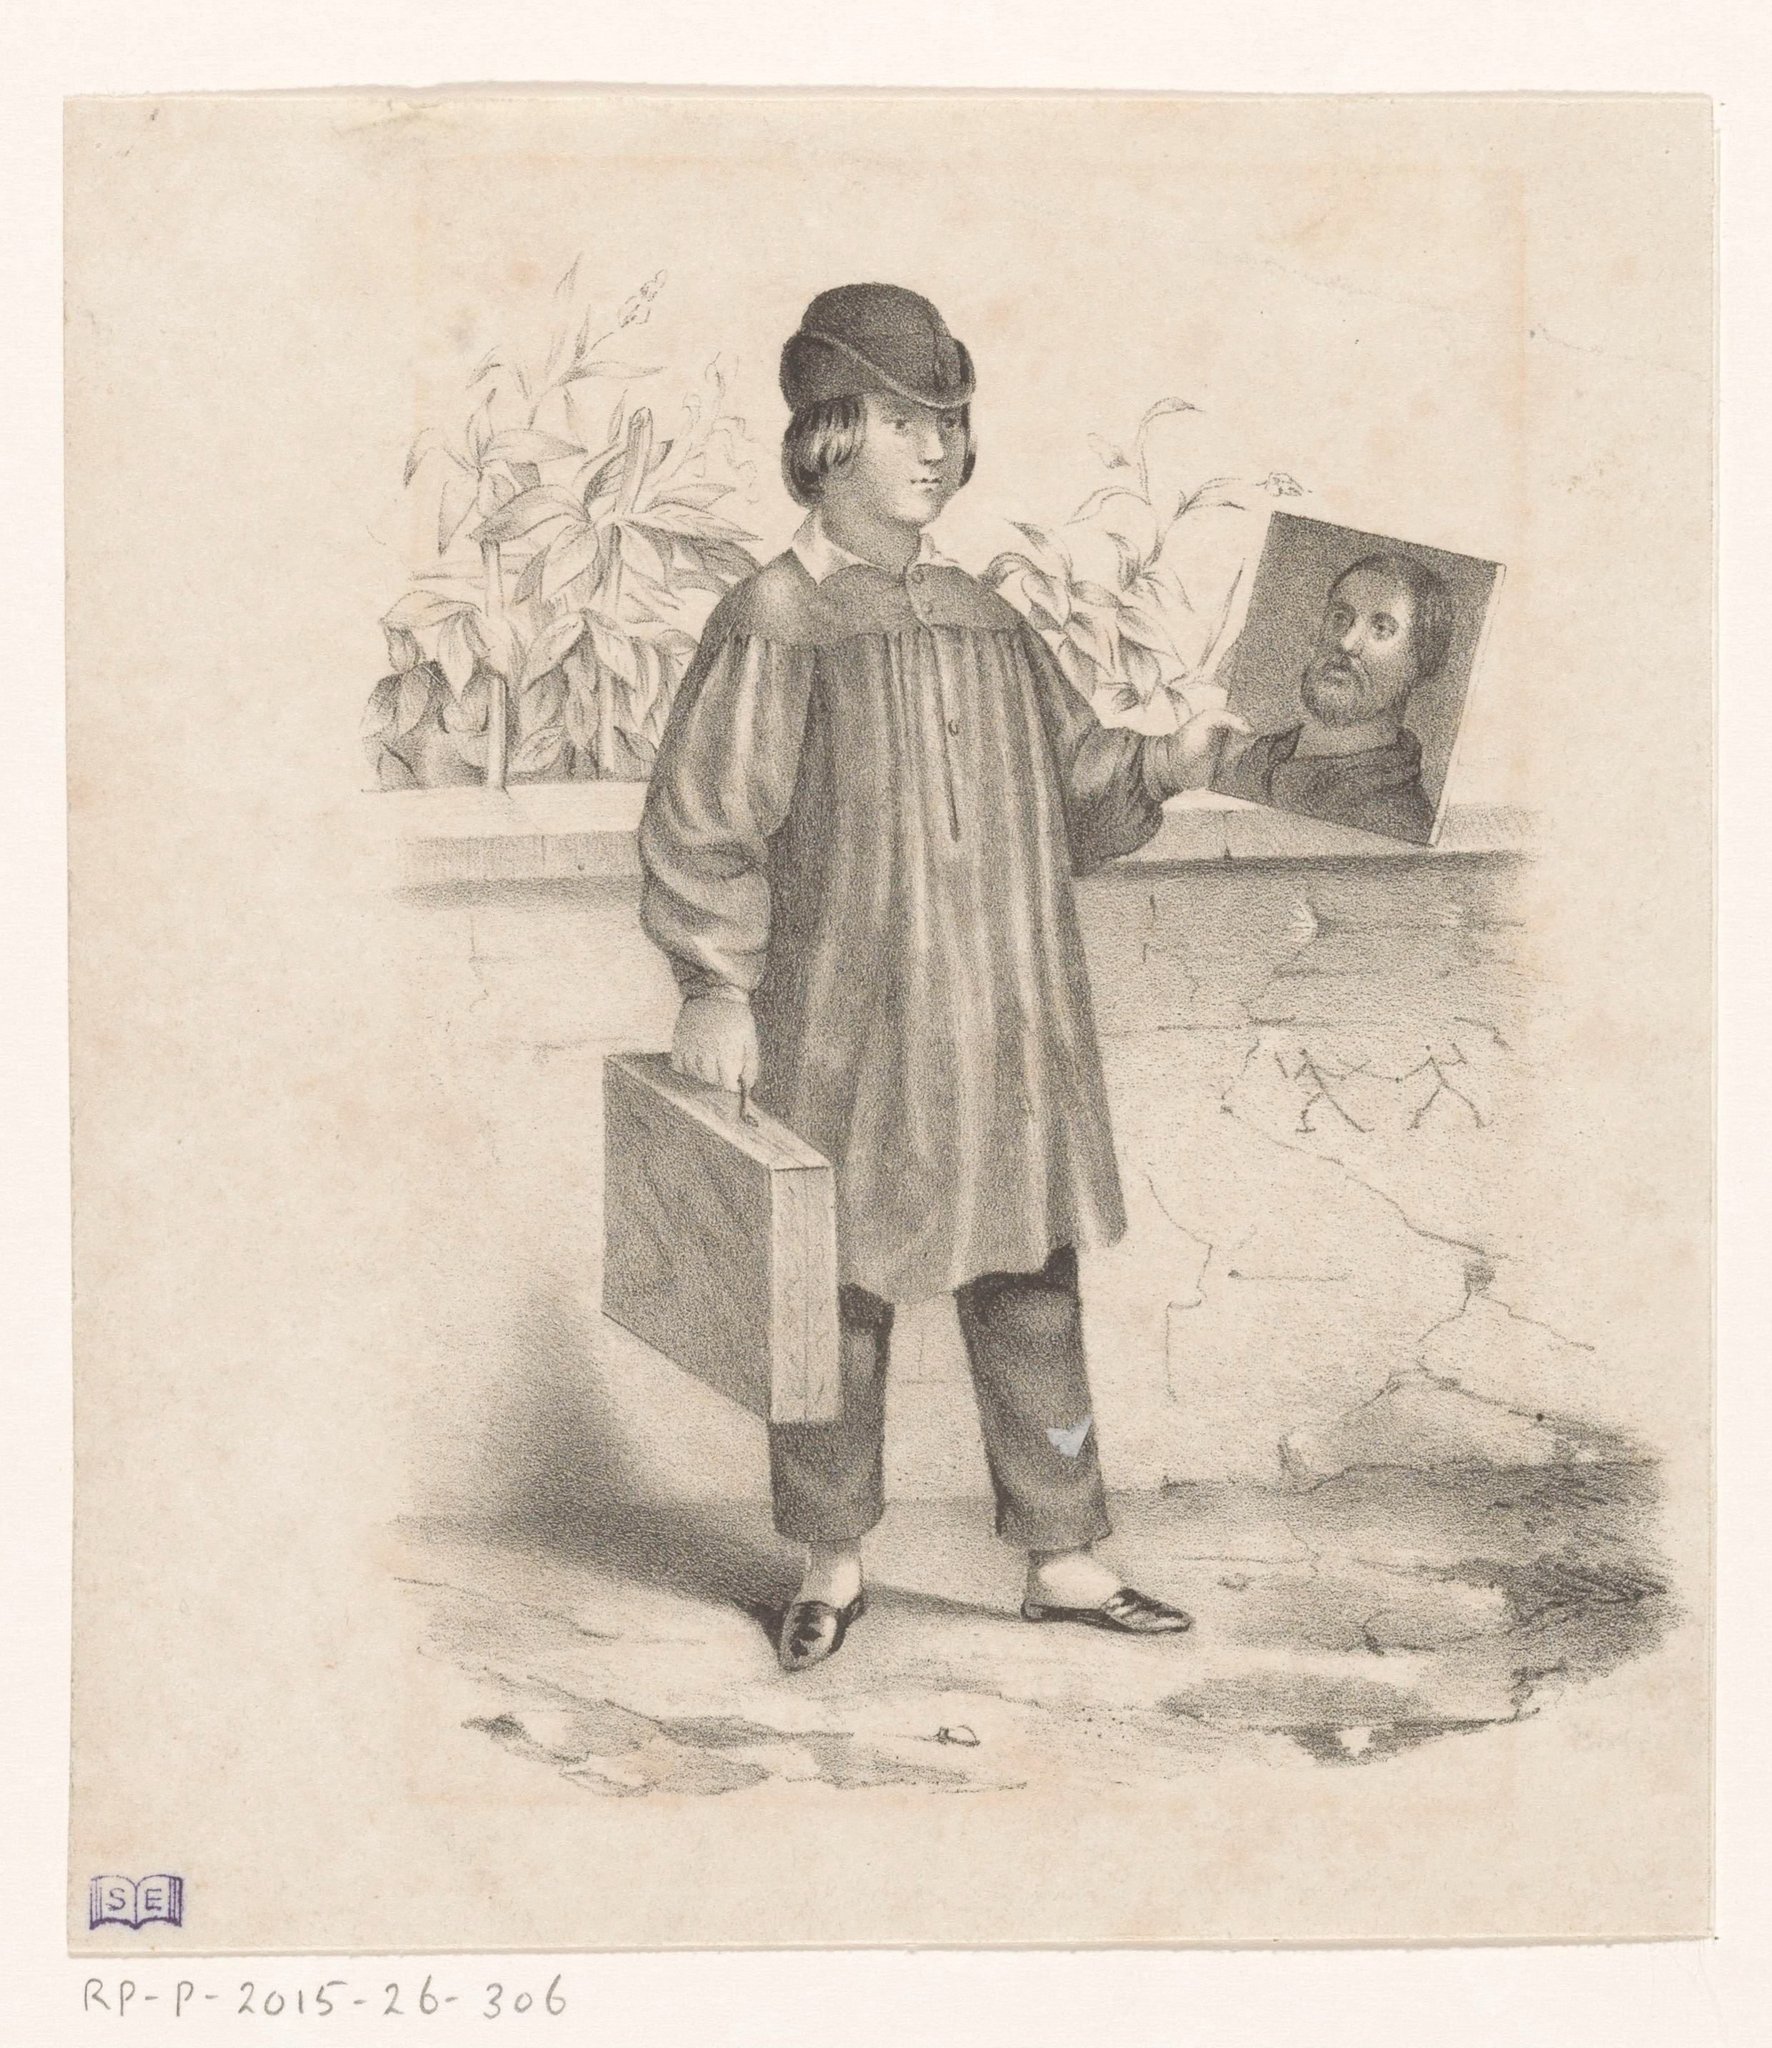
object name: print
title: Jongen met een portret in zijn hand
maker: Anonymous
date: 1809-1900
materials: paper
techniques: lithograph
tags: print, e.g.: engraving, etching, lithograph, anonymous historical person portrayed alone, trunk, suit-case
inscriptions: collector's mark: Lugt 2228, collector's mark: Lugt 4780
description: Jongen met in zijn linkerhand een portret en in zijn rechterhand een koffer. Achter hem een muur waar planten boven uit groeien.